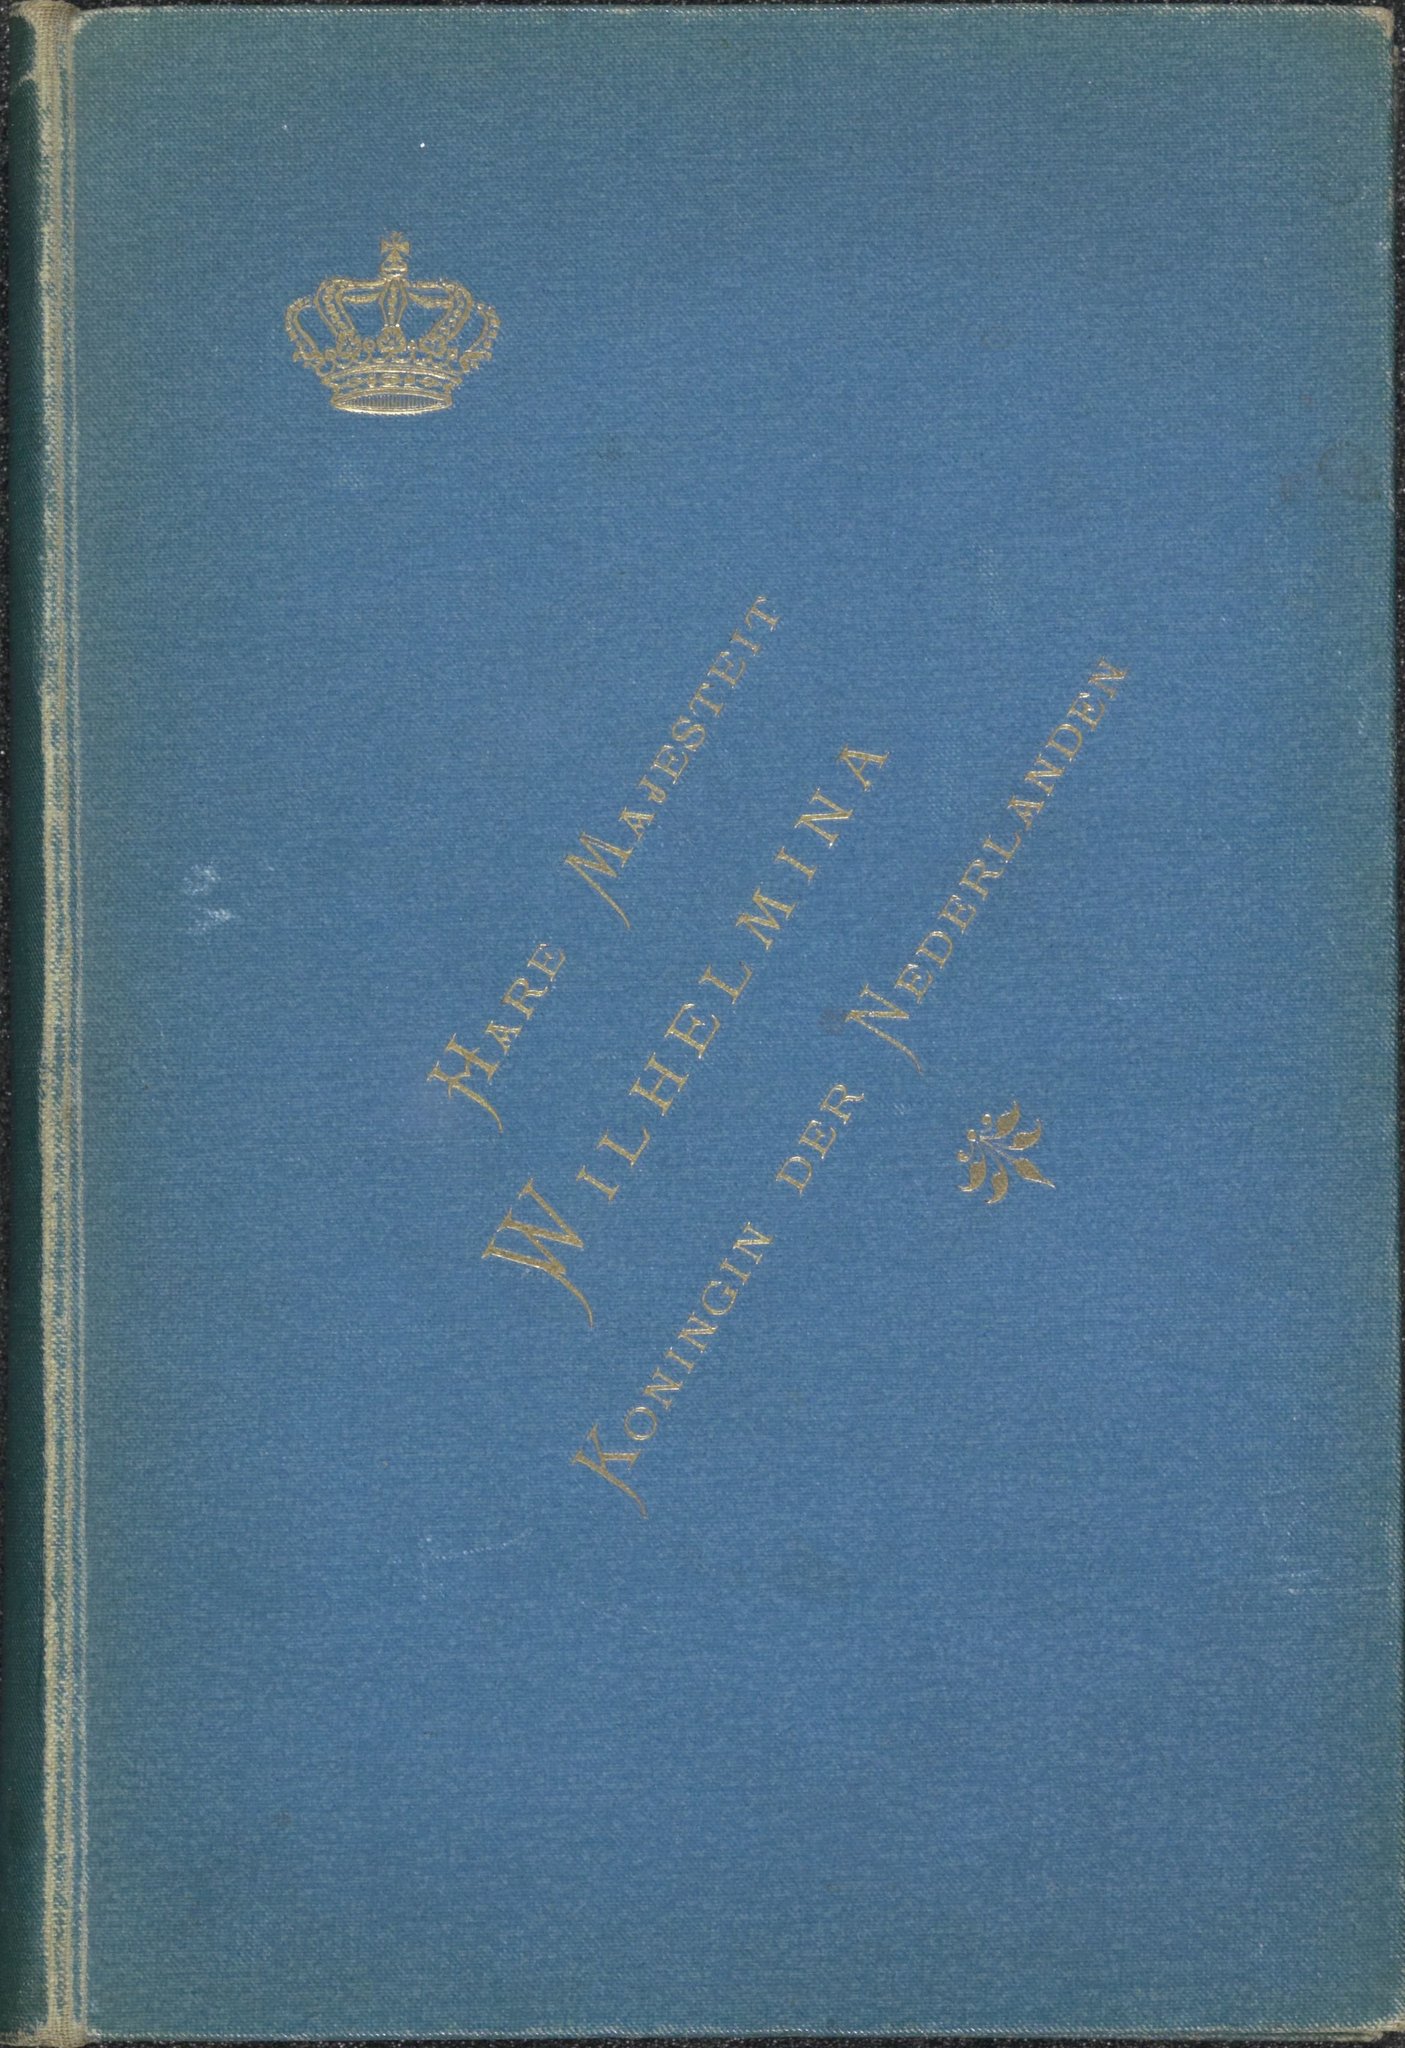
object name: accordion book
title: Fotoalbum met opnames van prinses Wilhelmina als kind tot aan haar inhuldiging in 1898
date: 1898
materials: cardboard, linen, paper, photographic support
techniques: albumen print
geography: netherlands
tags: the hague, print maker, wilhelmina of the netherlands, emma (queen consort of the netherlands), child, ruler, sovereign - bb - female ruler, netherlands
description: Leporelloalbum in blauwe linnen band. Op het voorplat de titel in gouddruk en in reliëf, versierd met een kroon en een blad. Op het achterplat de naam van de uitgever, eveneens in gouddruk en reliëf. Het album bevat twaalf aan elkaar vastzittende, uitklapbare kabinetfoto's. Het zijn opnames van prinses Wilhelmina, vanaf (naar schatting) haar tweede tot aan haar achttiende levensjaar, toen zij ingehuldigd werd als koningin. Vermoedelijk is het album ter gelegenheid daarvan samengesteld.